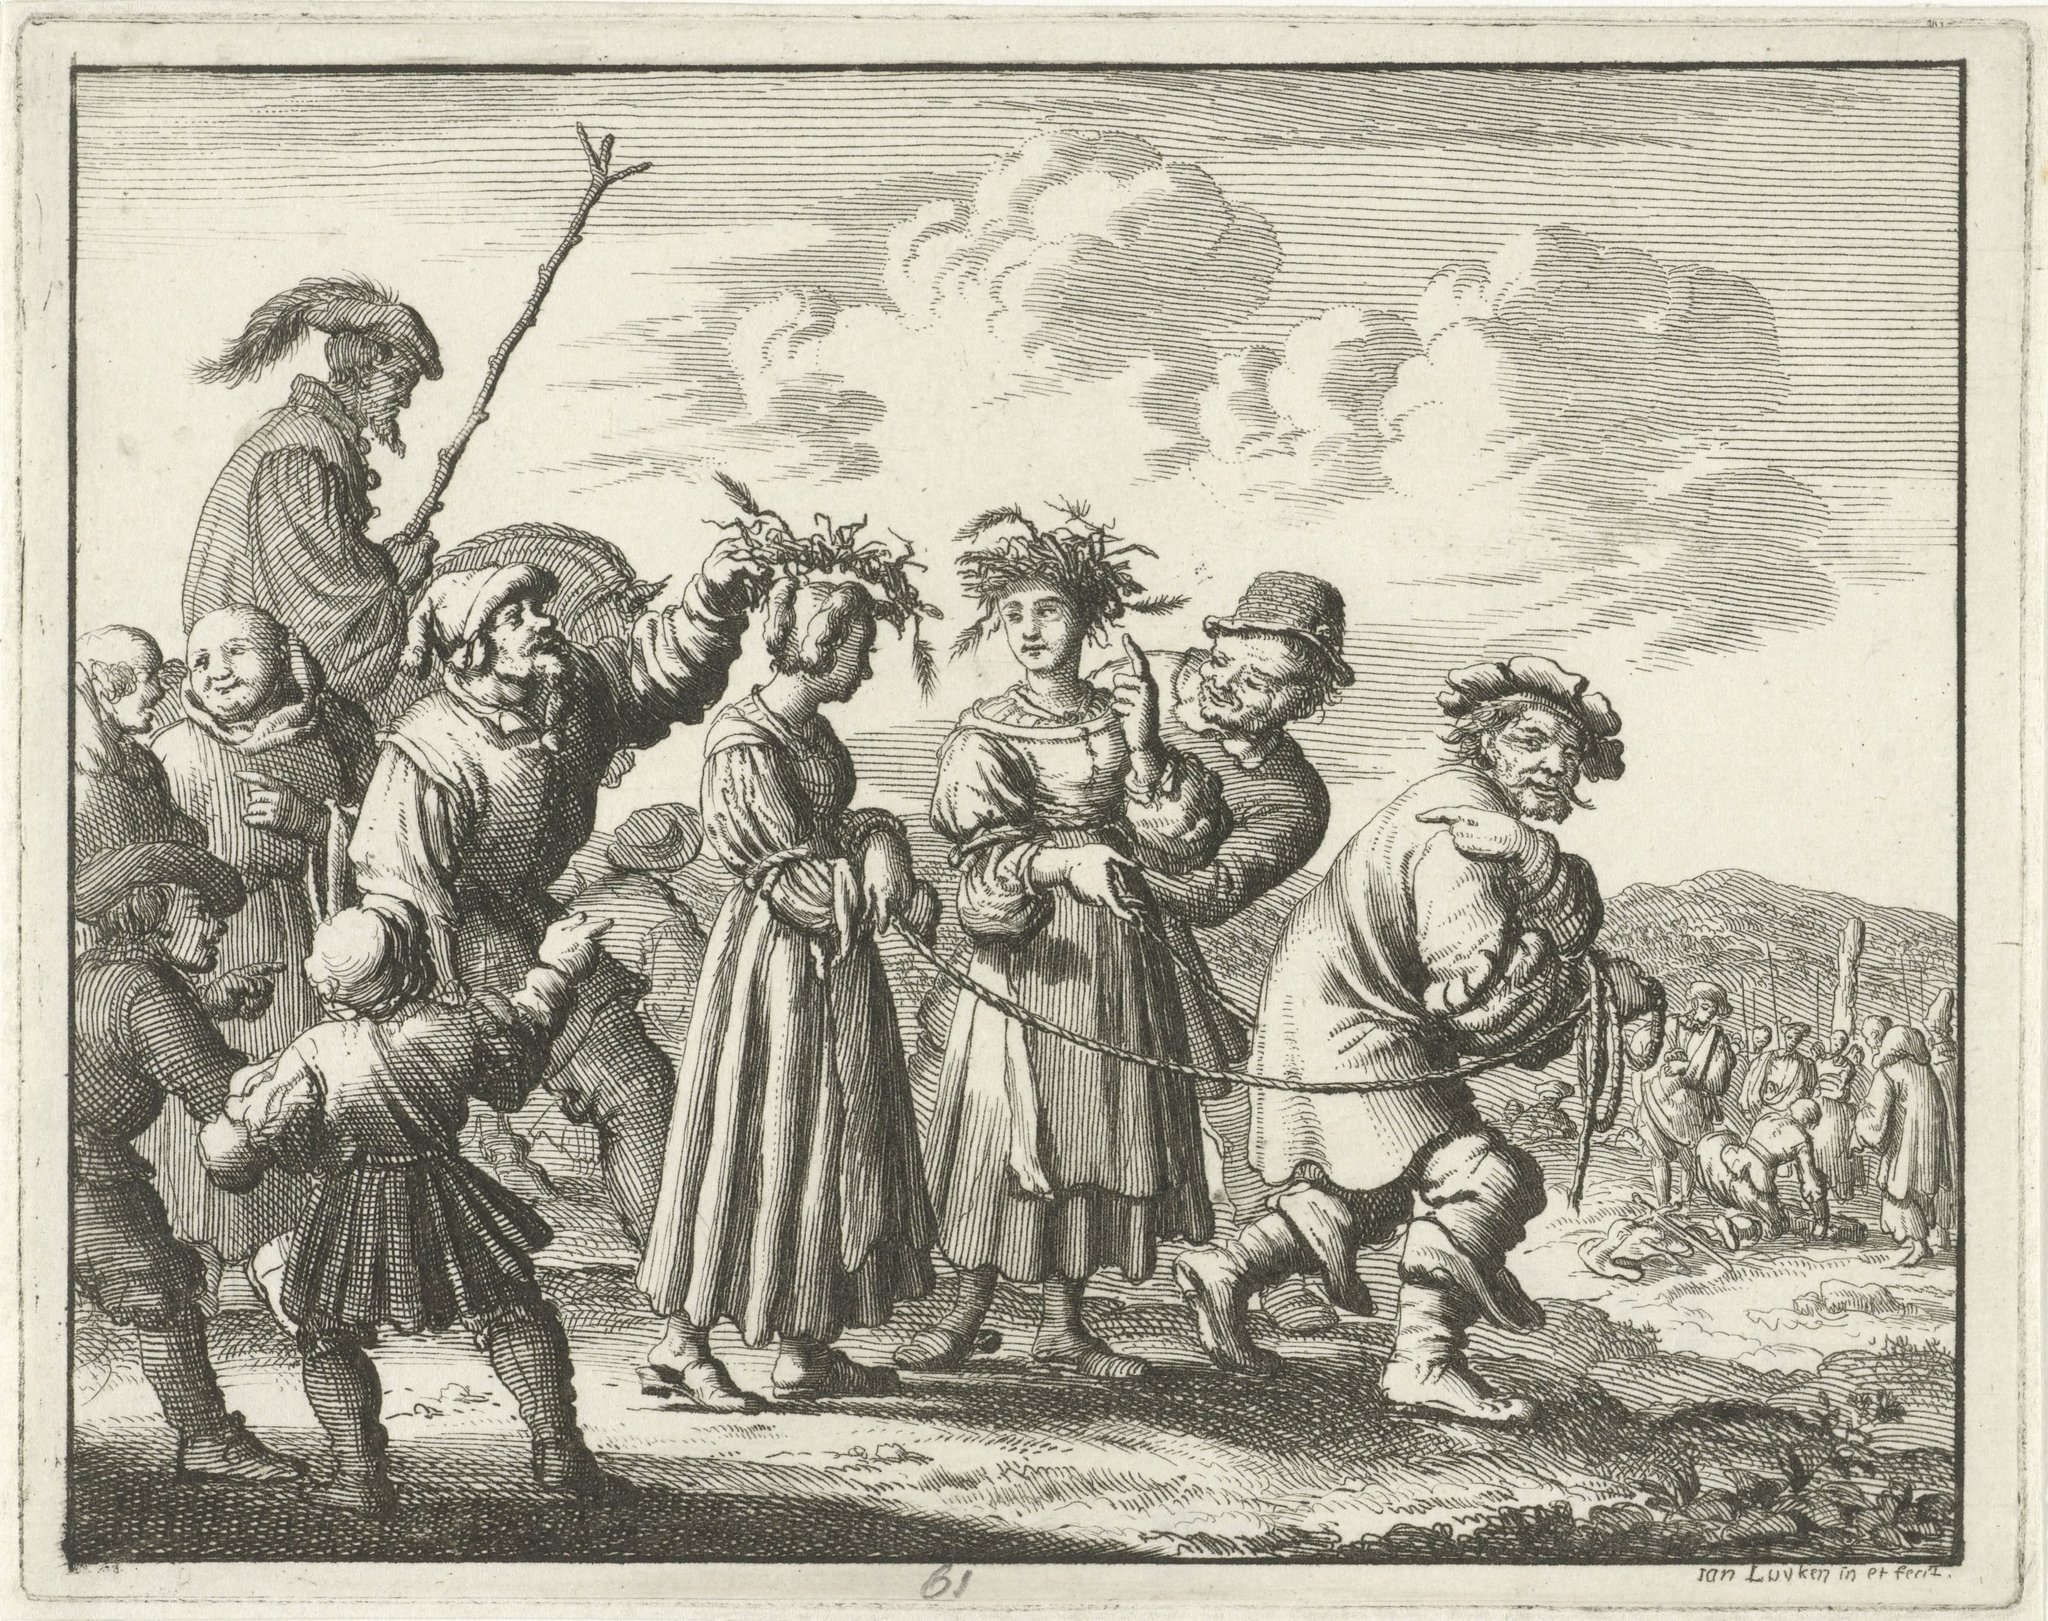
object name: print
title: Twee meisjes te Bamberg naar de brandstapel gevoerd, 1550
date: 1685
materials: paper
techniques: etching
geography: amsterdam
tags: violent death by burning at the stake; pyre, persecution of heretics, (person under sentence of death) on the way to the scaffold or place of execution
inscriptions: collector's mark: Lugt 2228, number: ‘61’